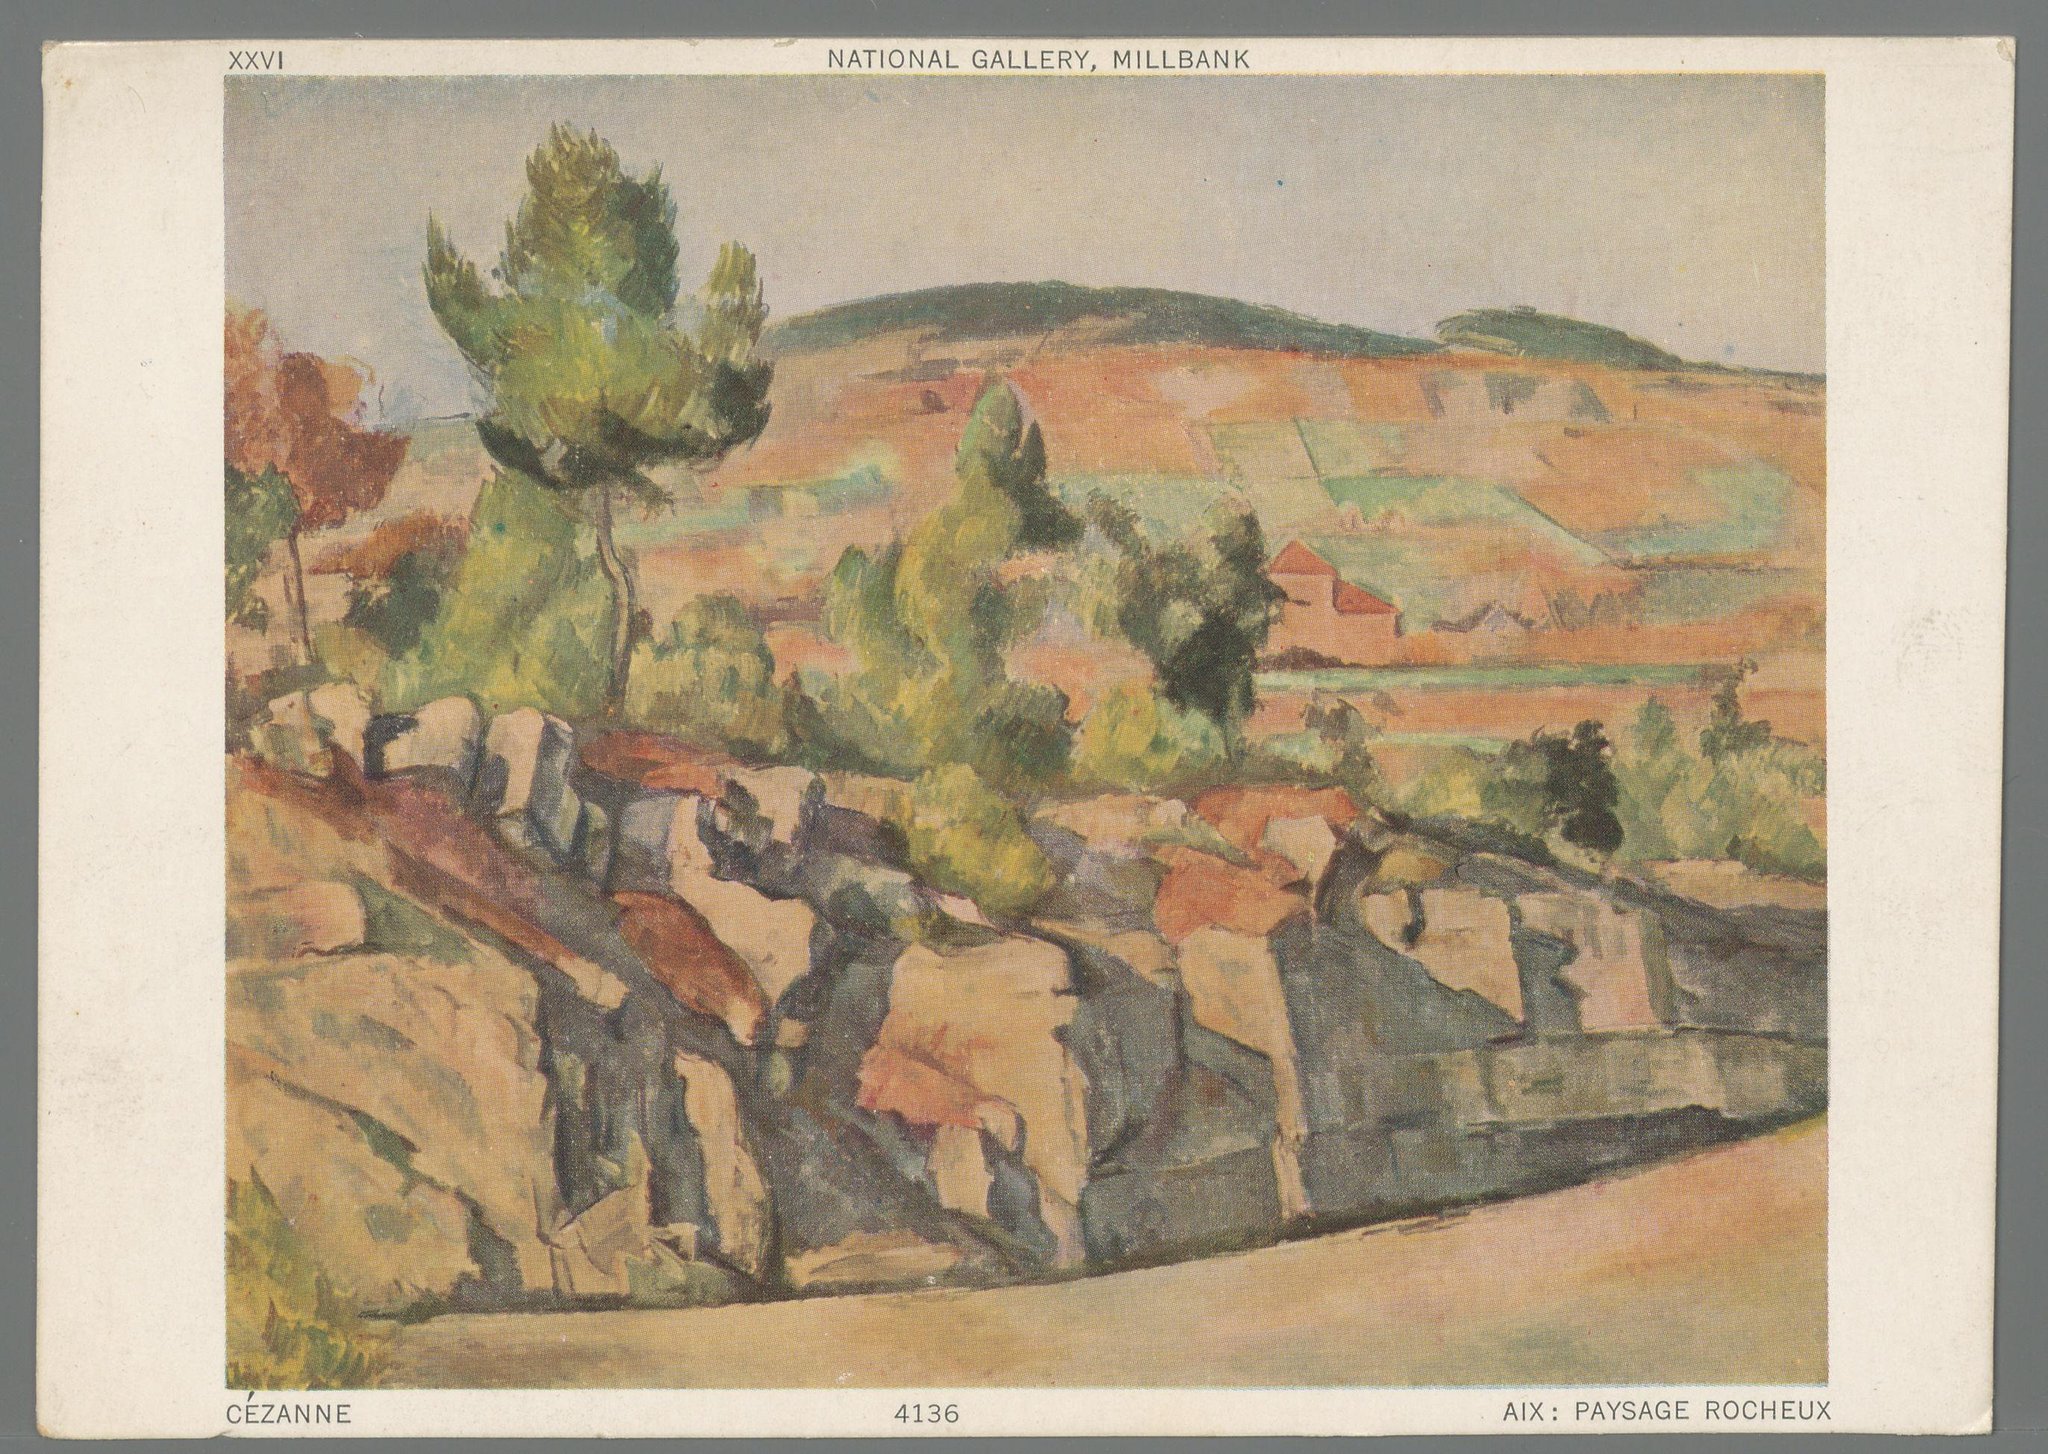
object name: photomechanical print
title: National Gallery, Millbank. Cézanne. Aix: Paysage Rocheux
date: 1902-1950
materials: cardboard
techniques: color autotype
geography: london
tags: permanent exhibition, museum, picture, painting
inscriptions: collector's mark: ‘AFE v S’